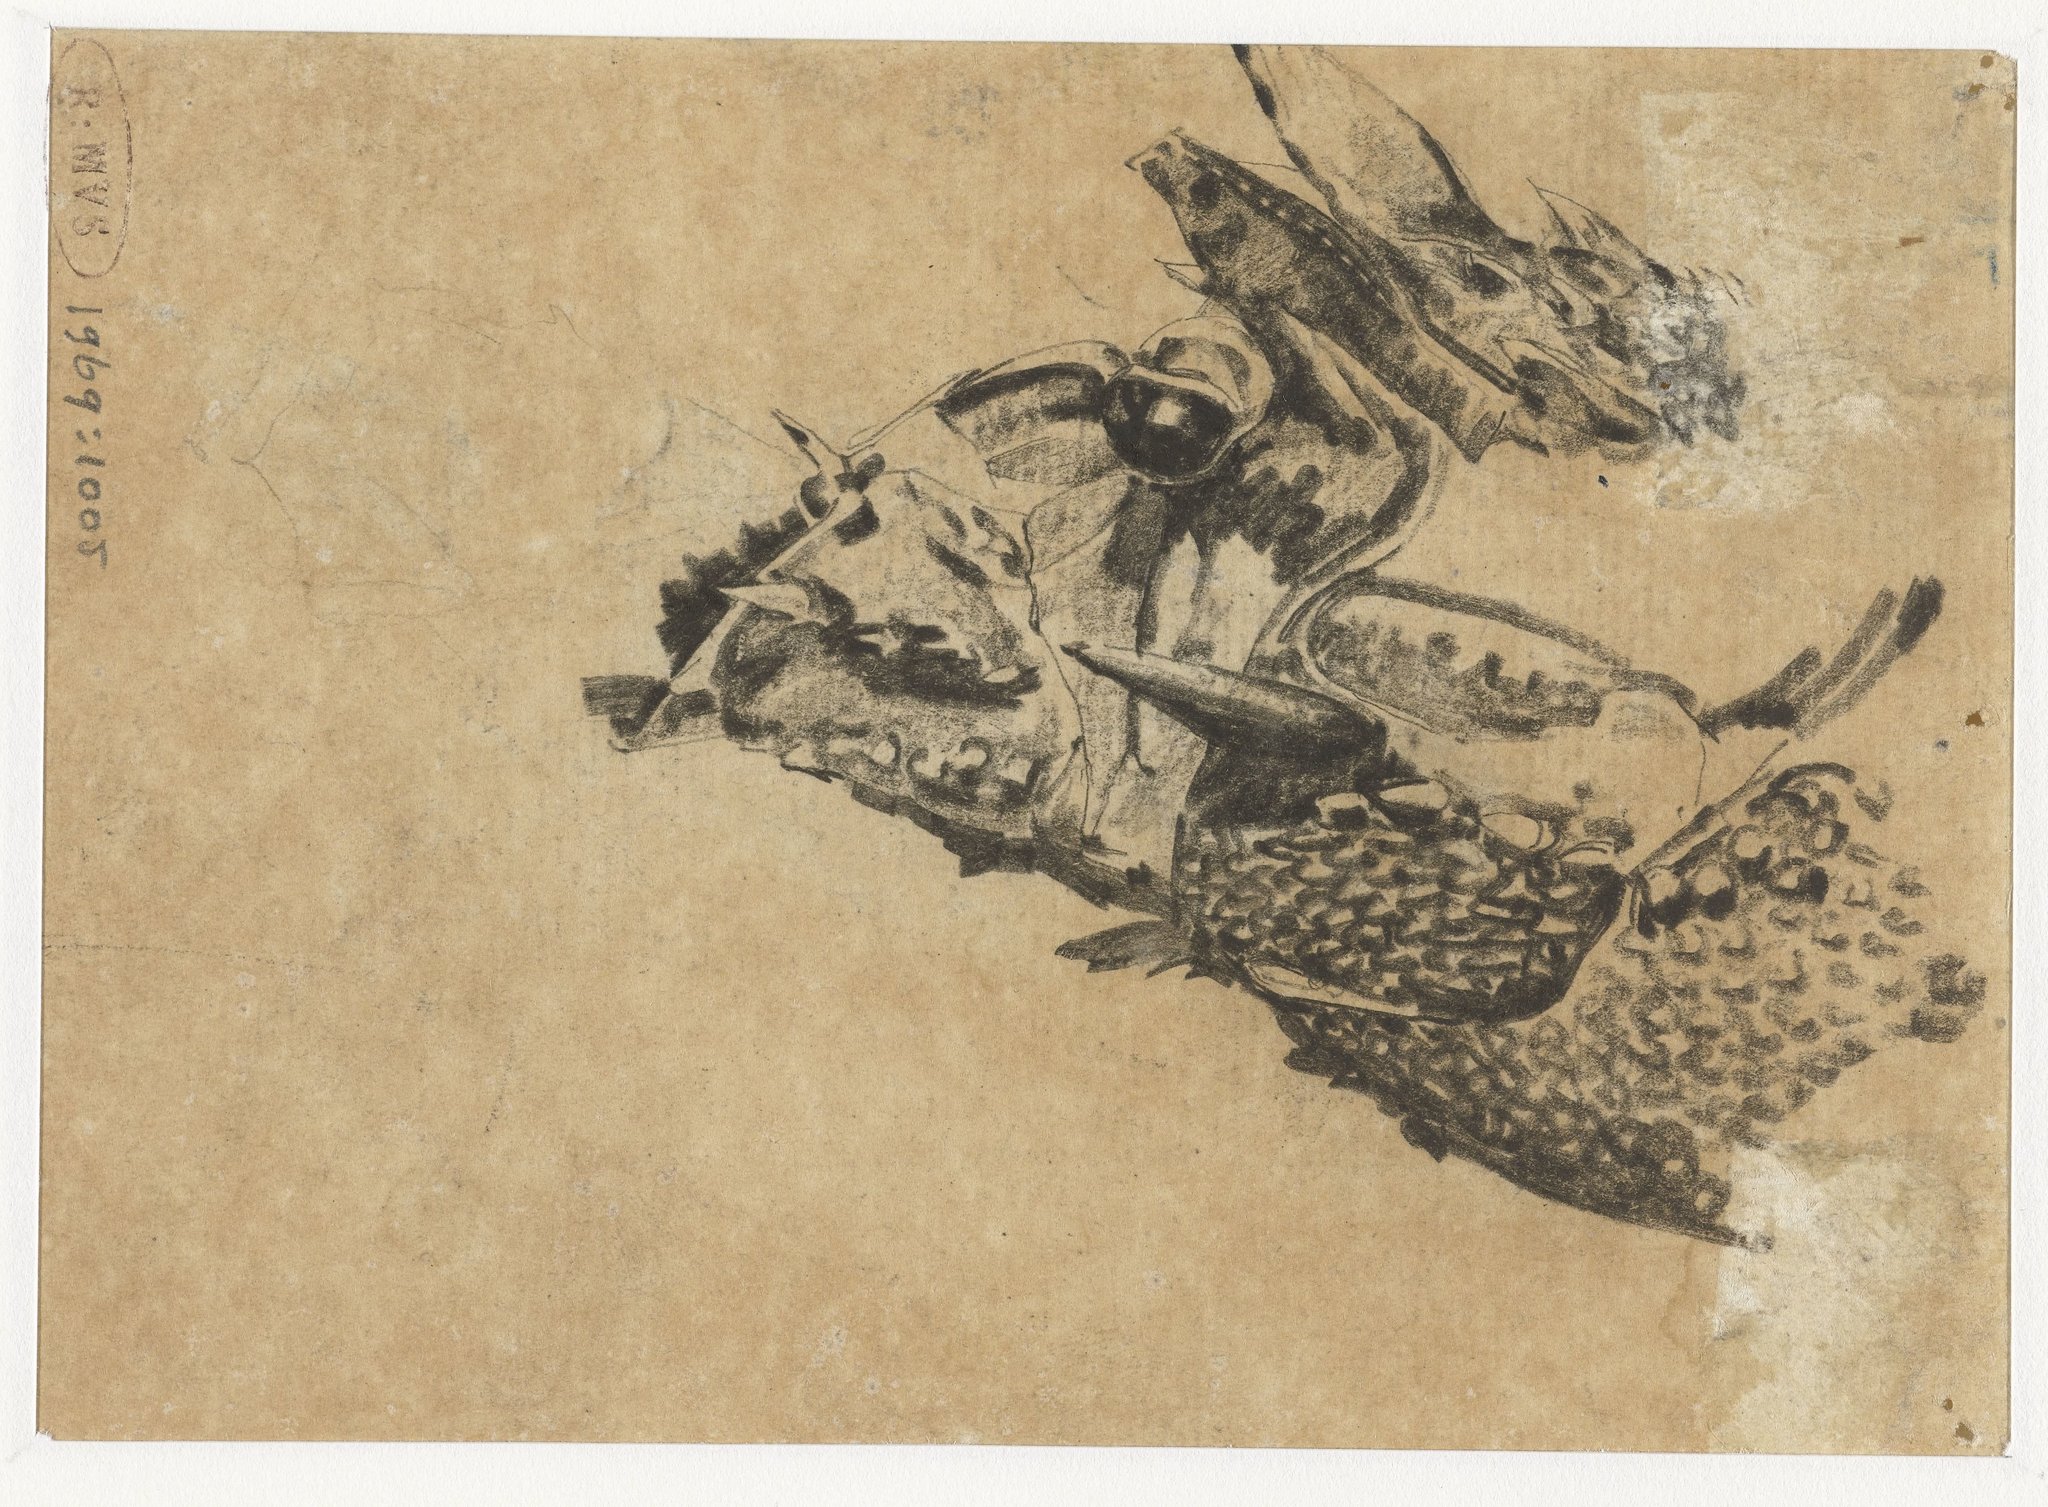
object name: drawing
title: Kop van een leguaan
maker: gerrit willem dijsselhof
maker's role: designer, draughtsman, print maker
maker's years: 1866-1924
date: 1876-1924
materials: chalk, paper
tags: lizards: iguana